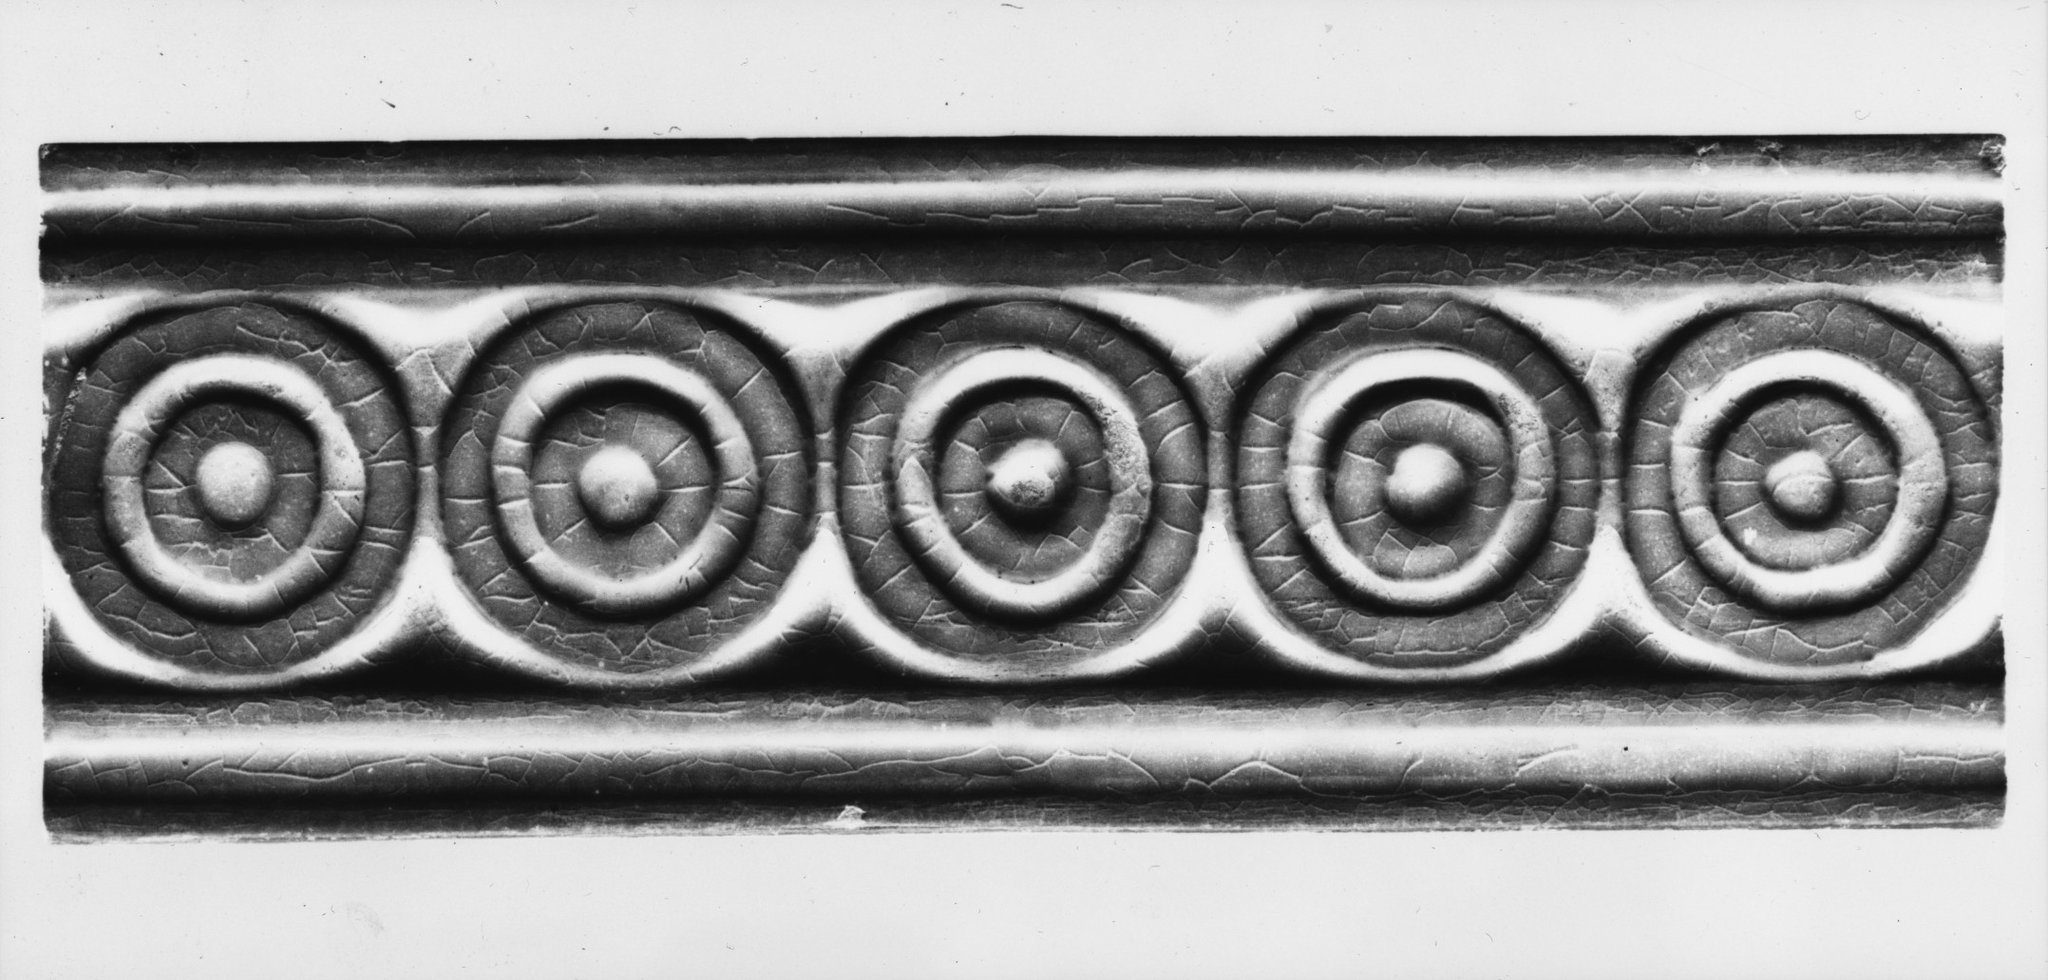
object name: tile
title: Border Tile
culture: american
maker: j. and j. g. low art tile works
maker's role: maker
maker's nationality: american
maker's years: 1877-1903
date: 1885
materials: earthenware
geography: united states